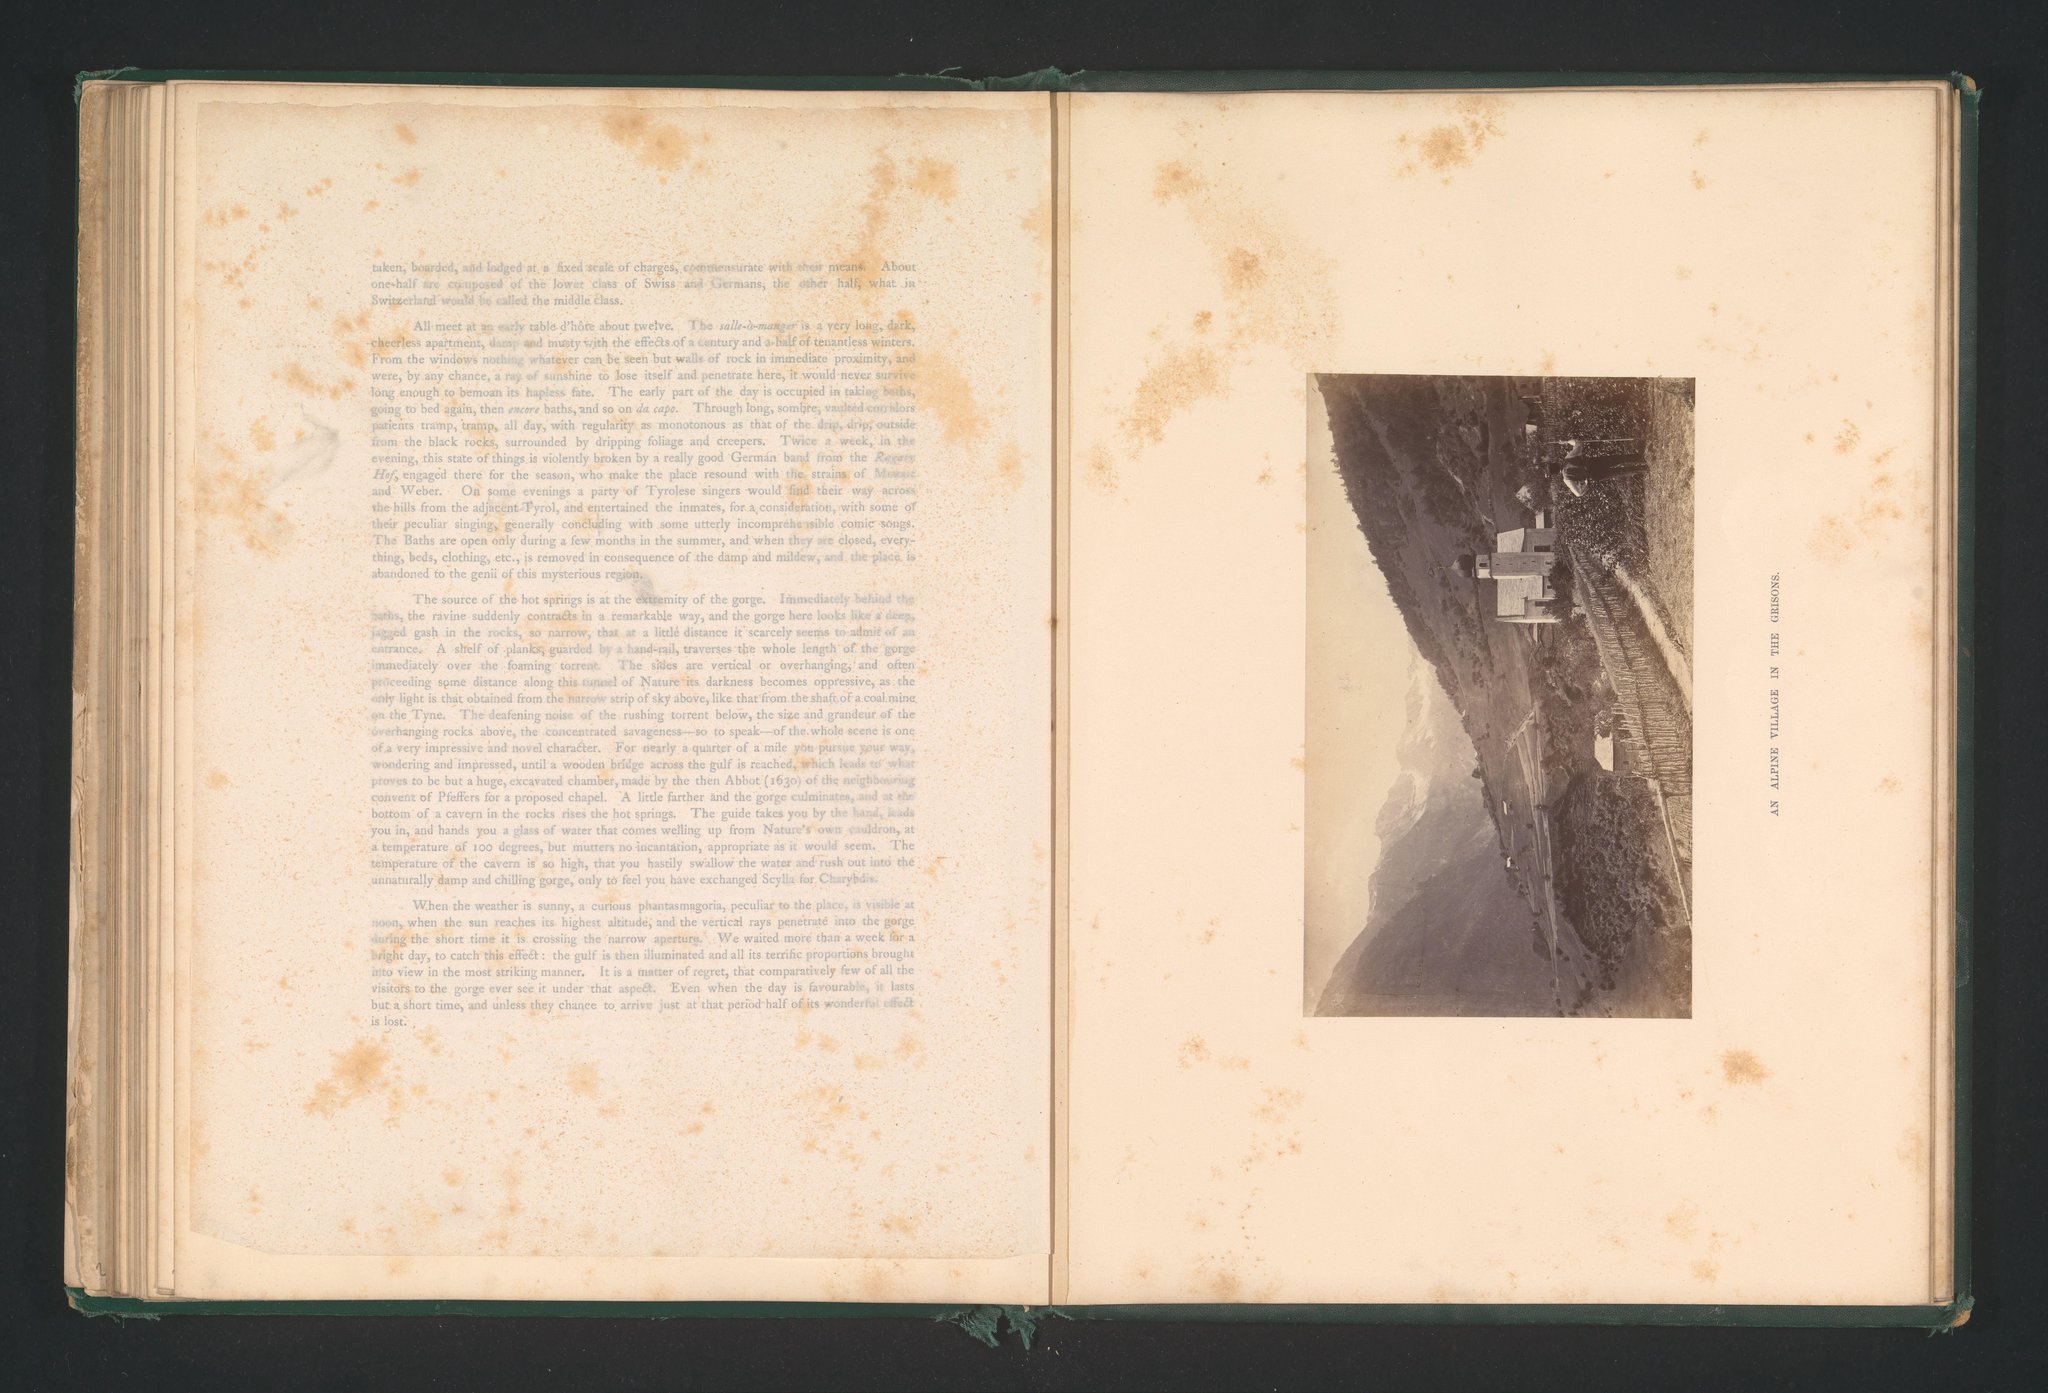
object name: page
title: Gezicht op een dorp in Graubünden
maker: stephen thompson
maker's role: fotograaf, schrijver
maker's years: 1831-1893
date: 1863-1868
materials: photographic support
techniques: albumen print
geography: graubunden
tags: street (+ city(-scape) with figures, staffage), mountains